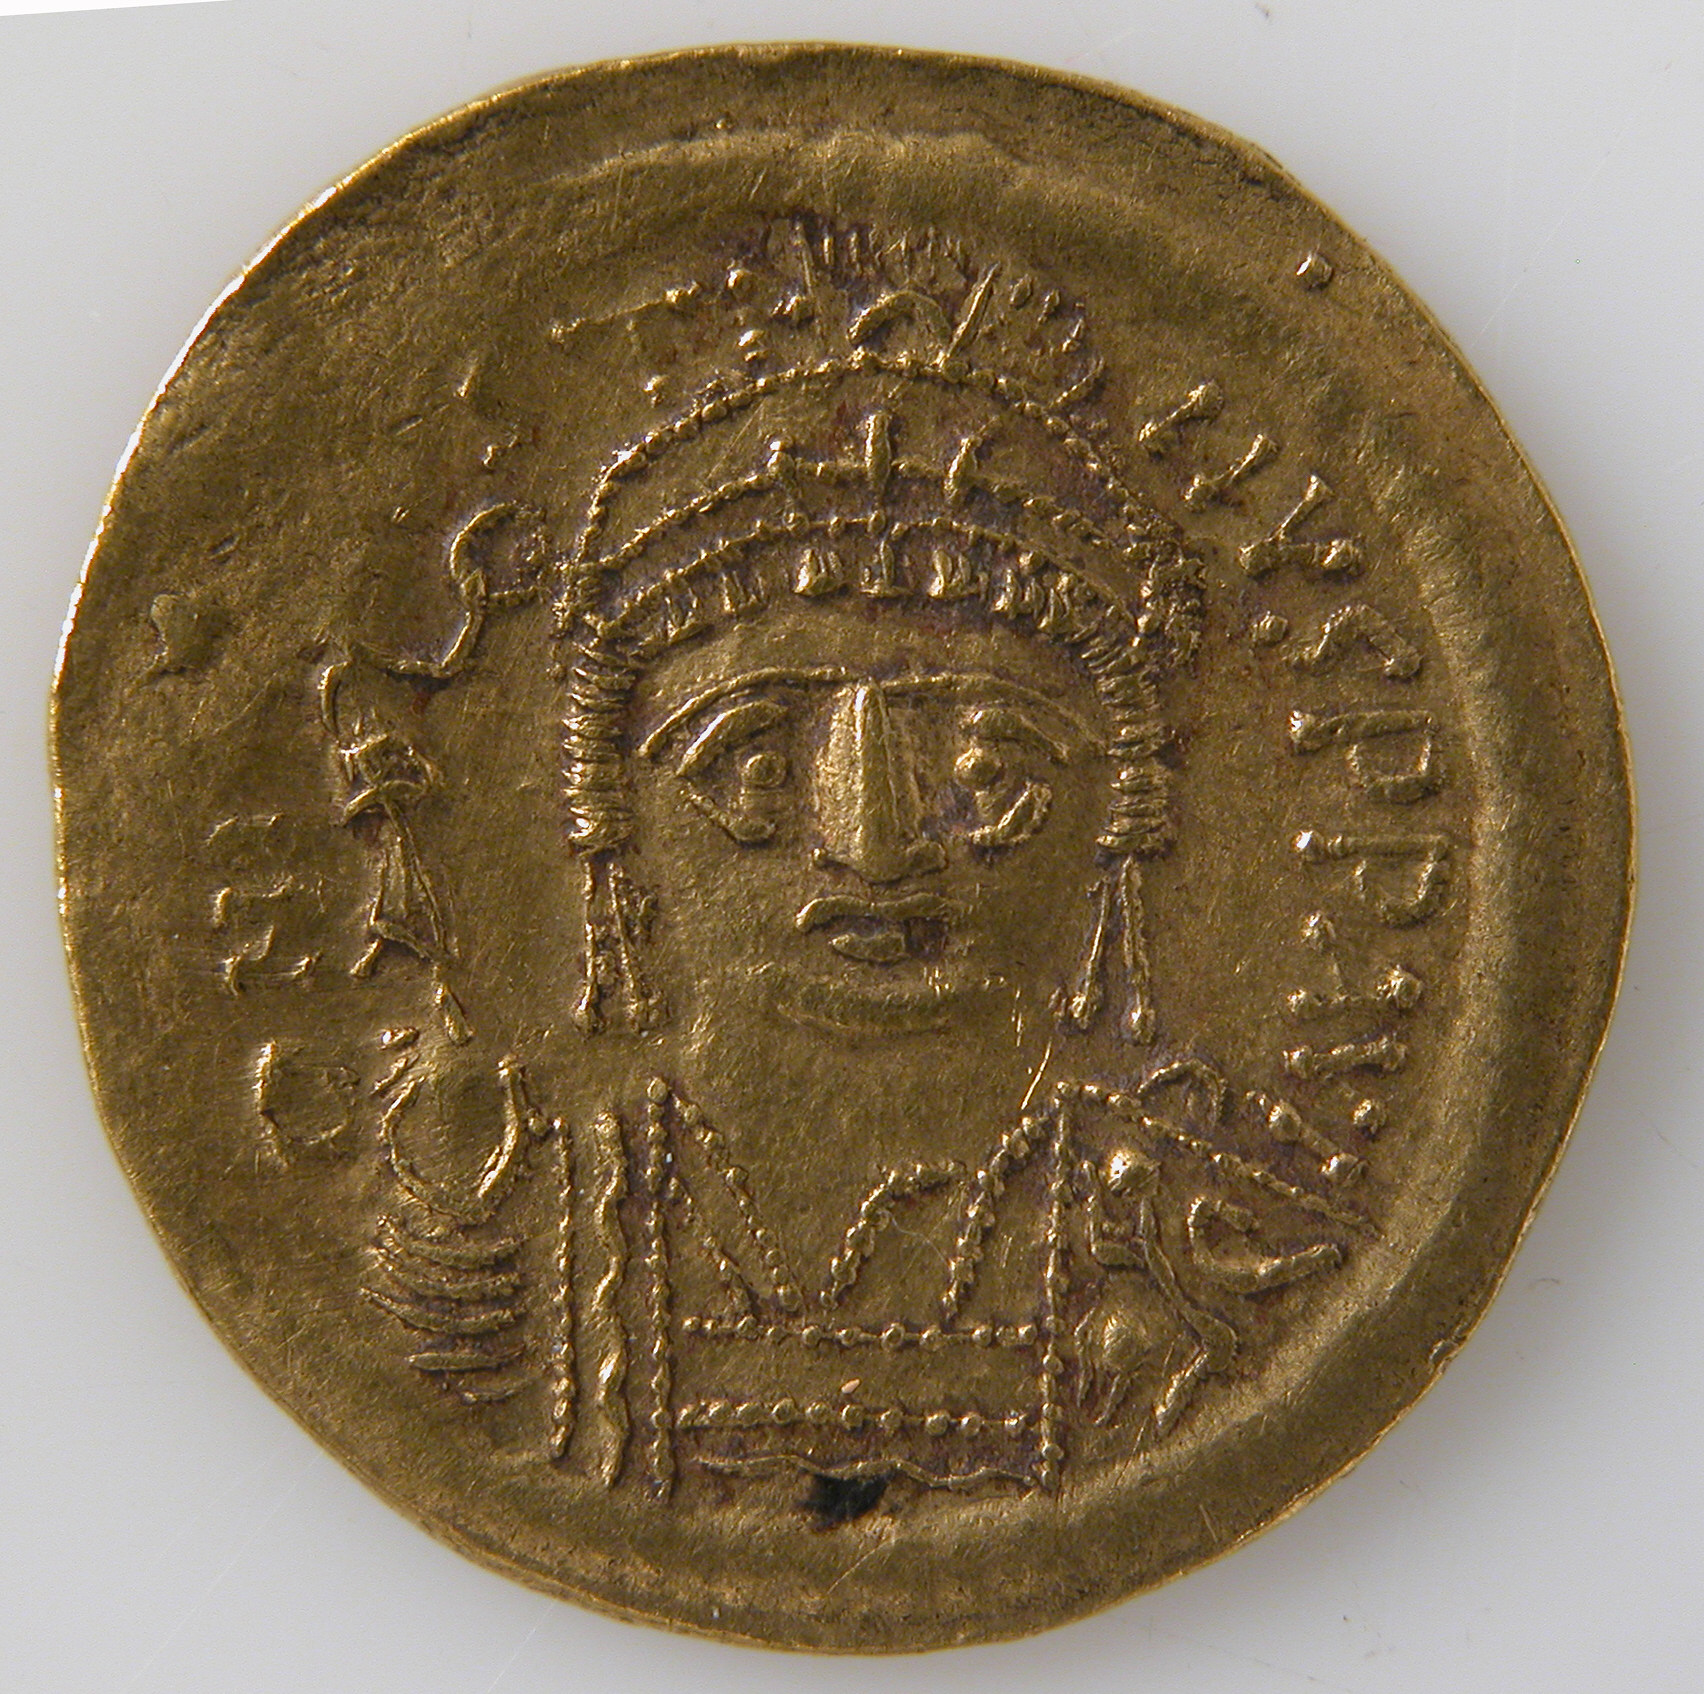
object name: solidus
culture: byzantine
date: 565-578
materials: gold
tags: human figures,faces,coins